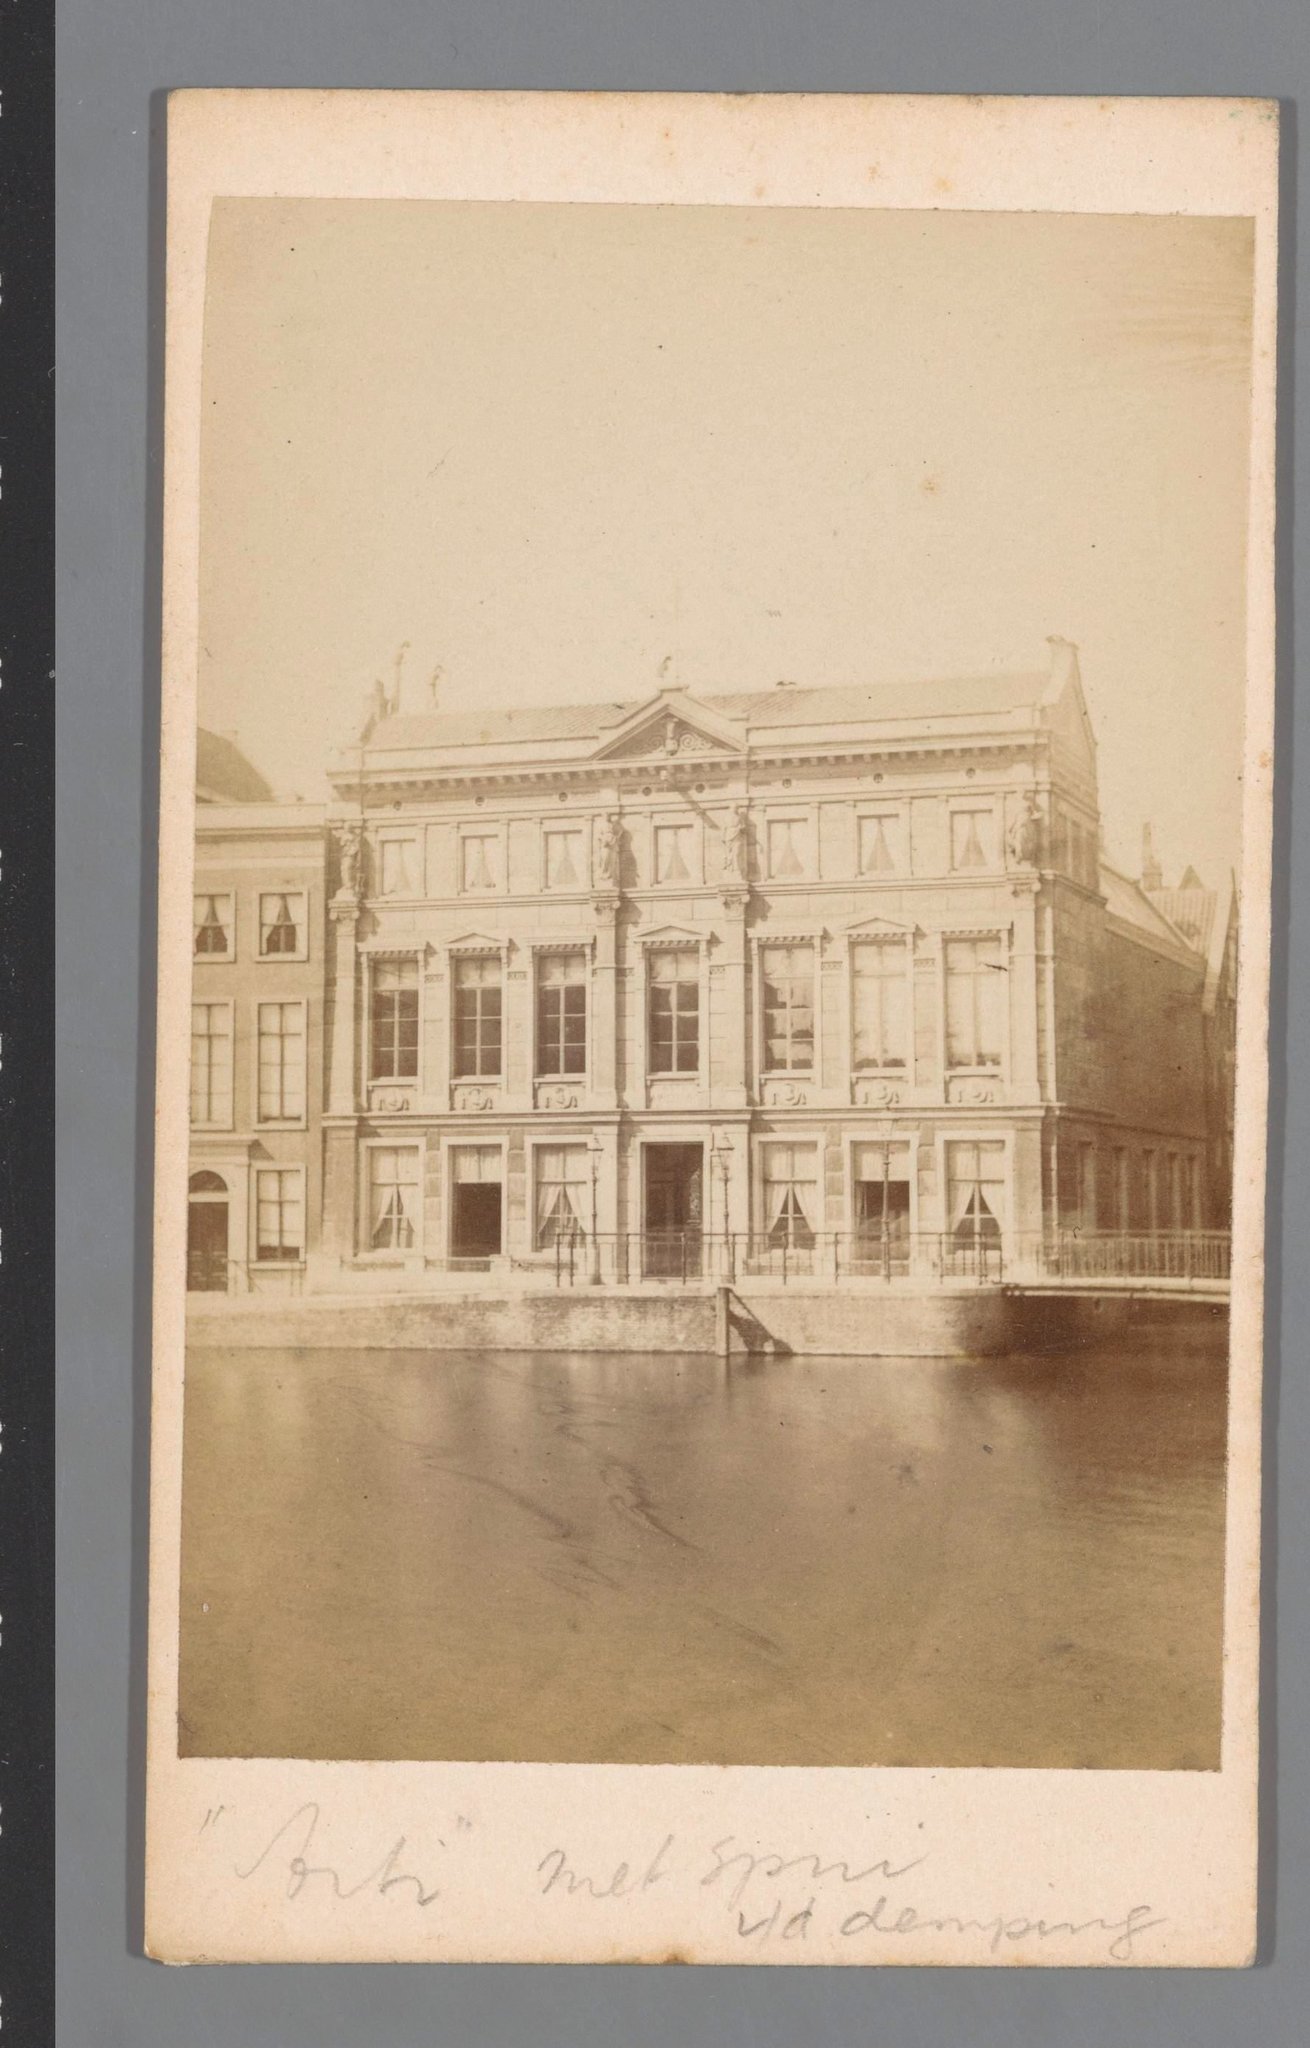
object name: carte de visite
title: Gezicht op de sociëteit Arti et Amicitiae aan het Rokin, hoek Spui in Amsterdam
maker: Anonymous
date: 1850-1882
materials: cardboard, photographic support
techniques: albumen print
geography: amsterdam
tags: club, meeting place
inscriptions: name: ‘A. Braun?’, annotation: ‘"Arti" met Spui/ v/d demping’